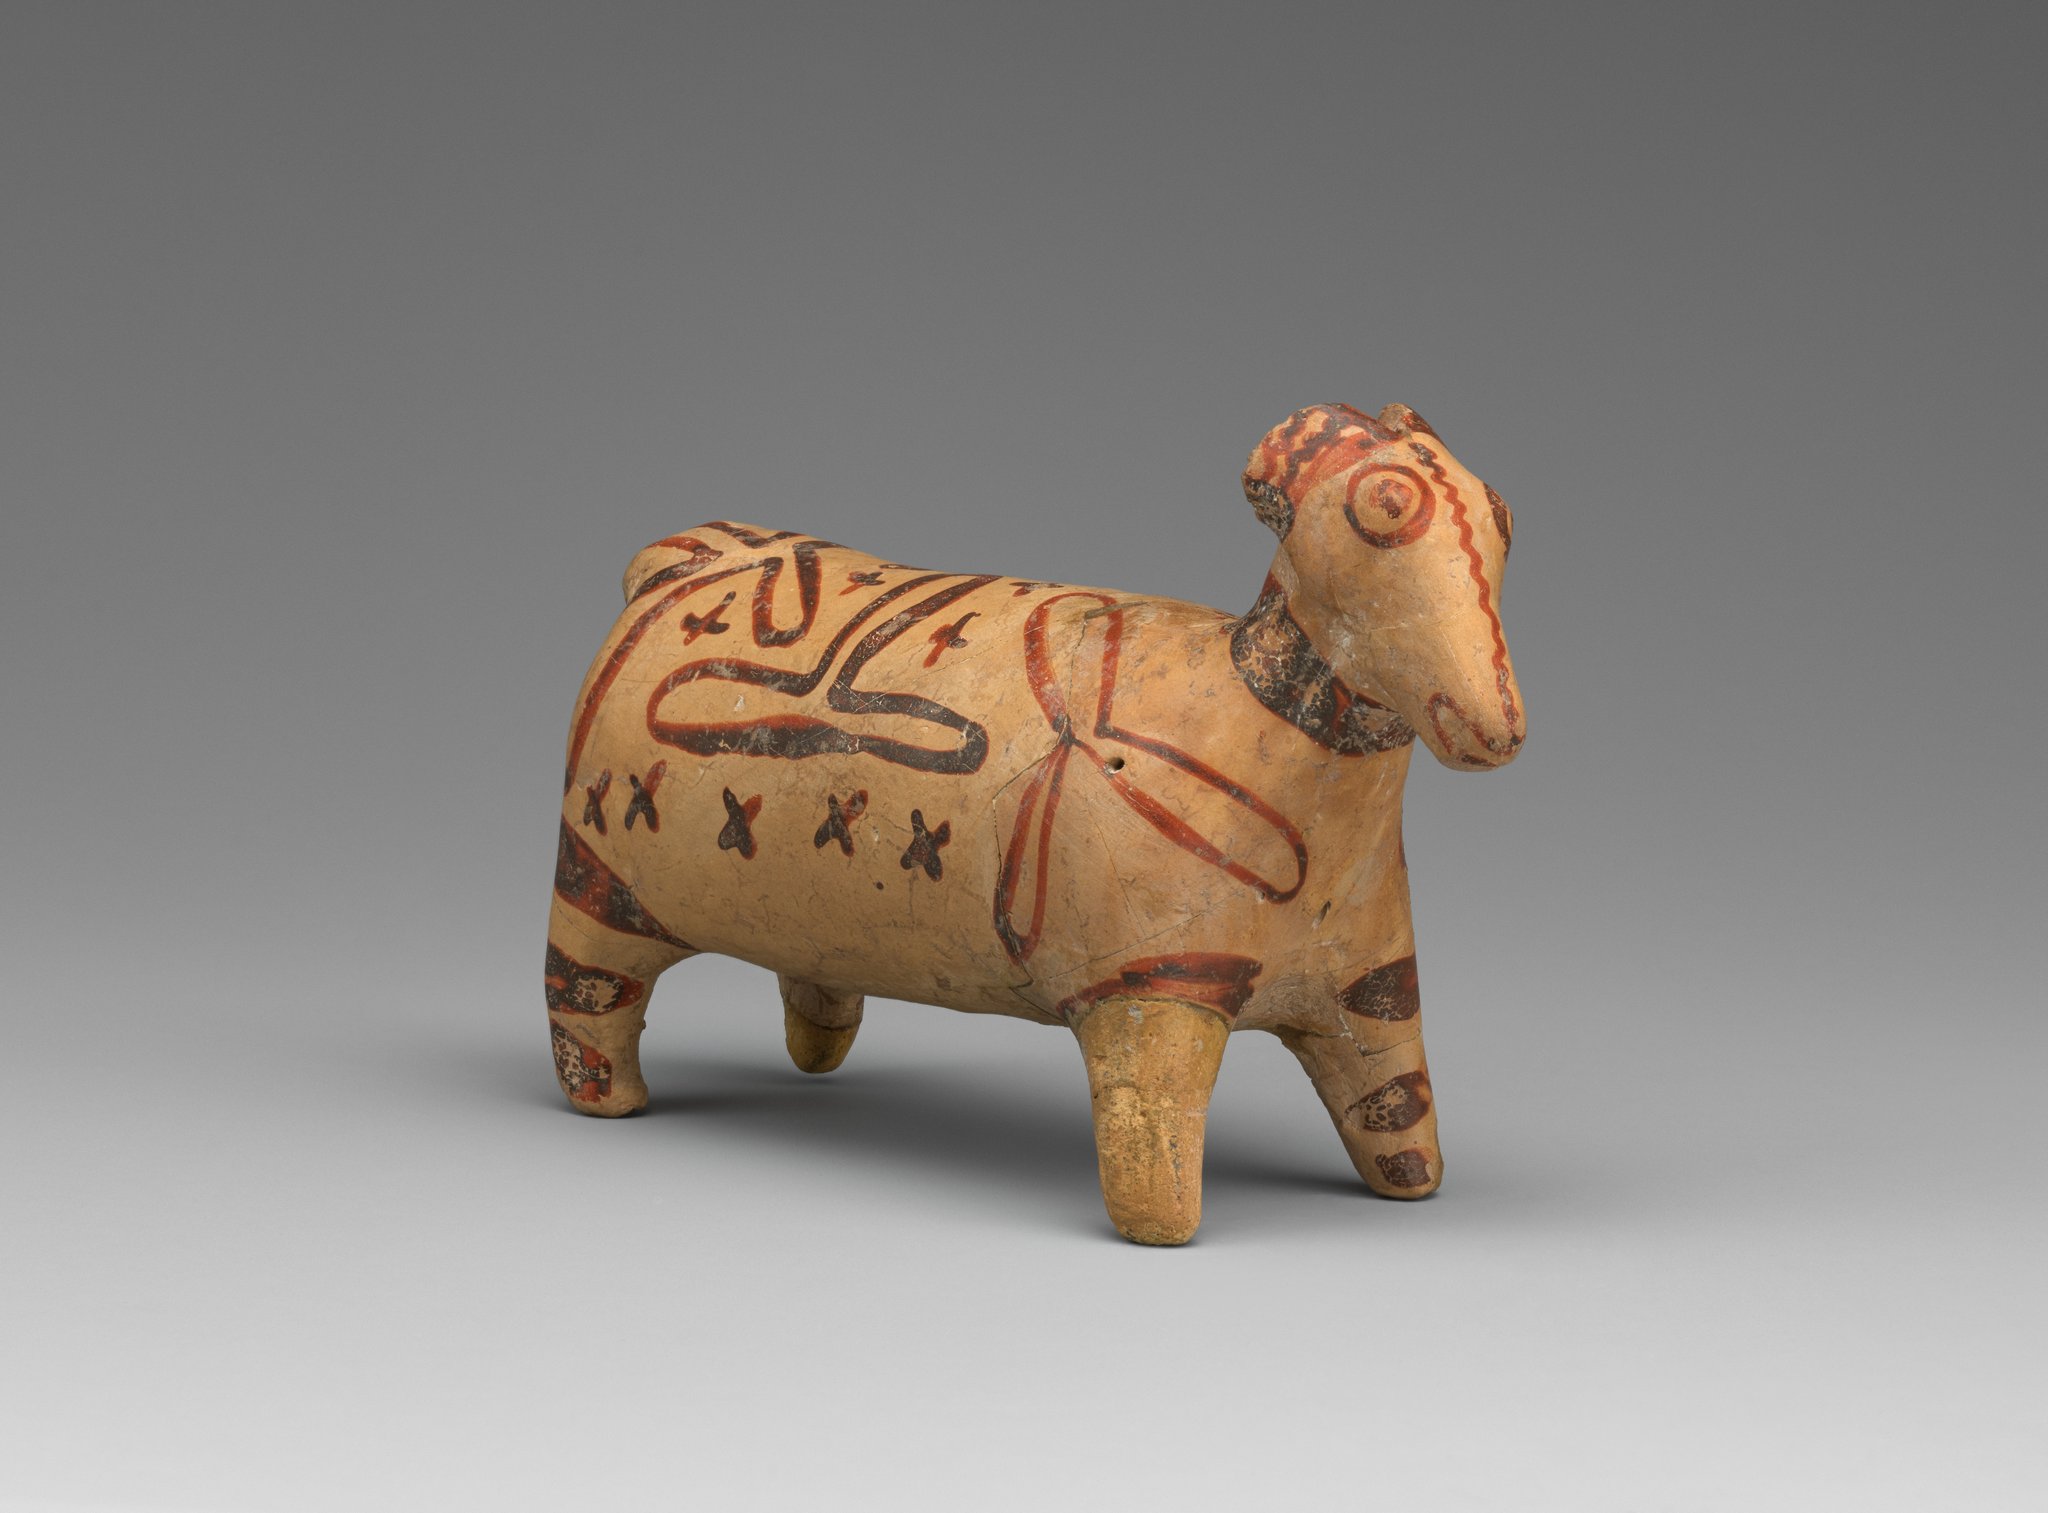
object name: statuette of a sheep or bull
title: Terracotta sheep or bull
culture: aegean, helladic or mycenaean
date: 1400-1300 BCE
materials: terracotta